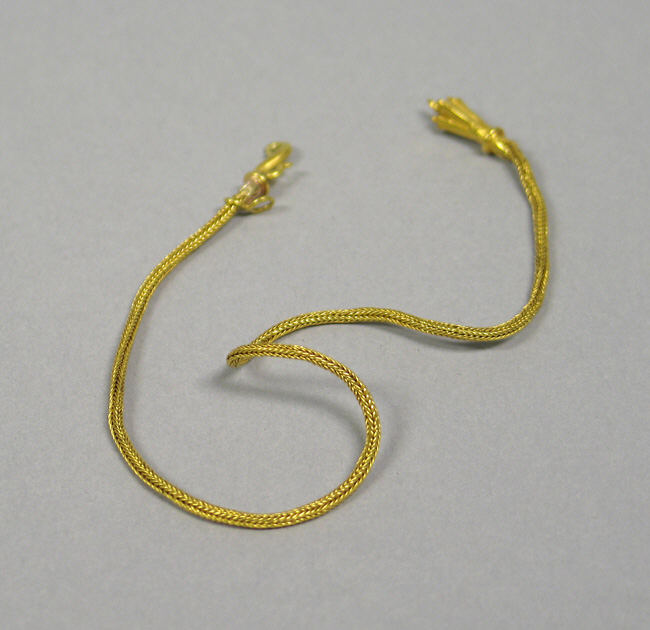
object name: chain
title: Braided Wire Chain with Clasp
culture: indonesian, javanese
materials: gold